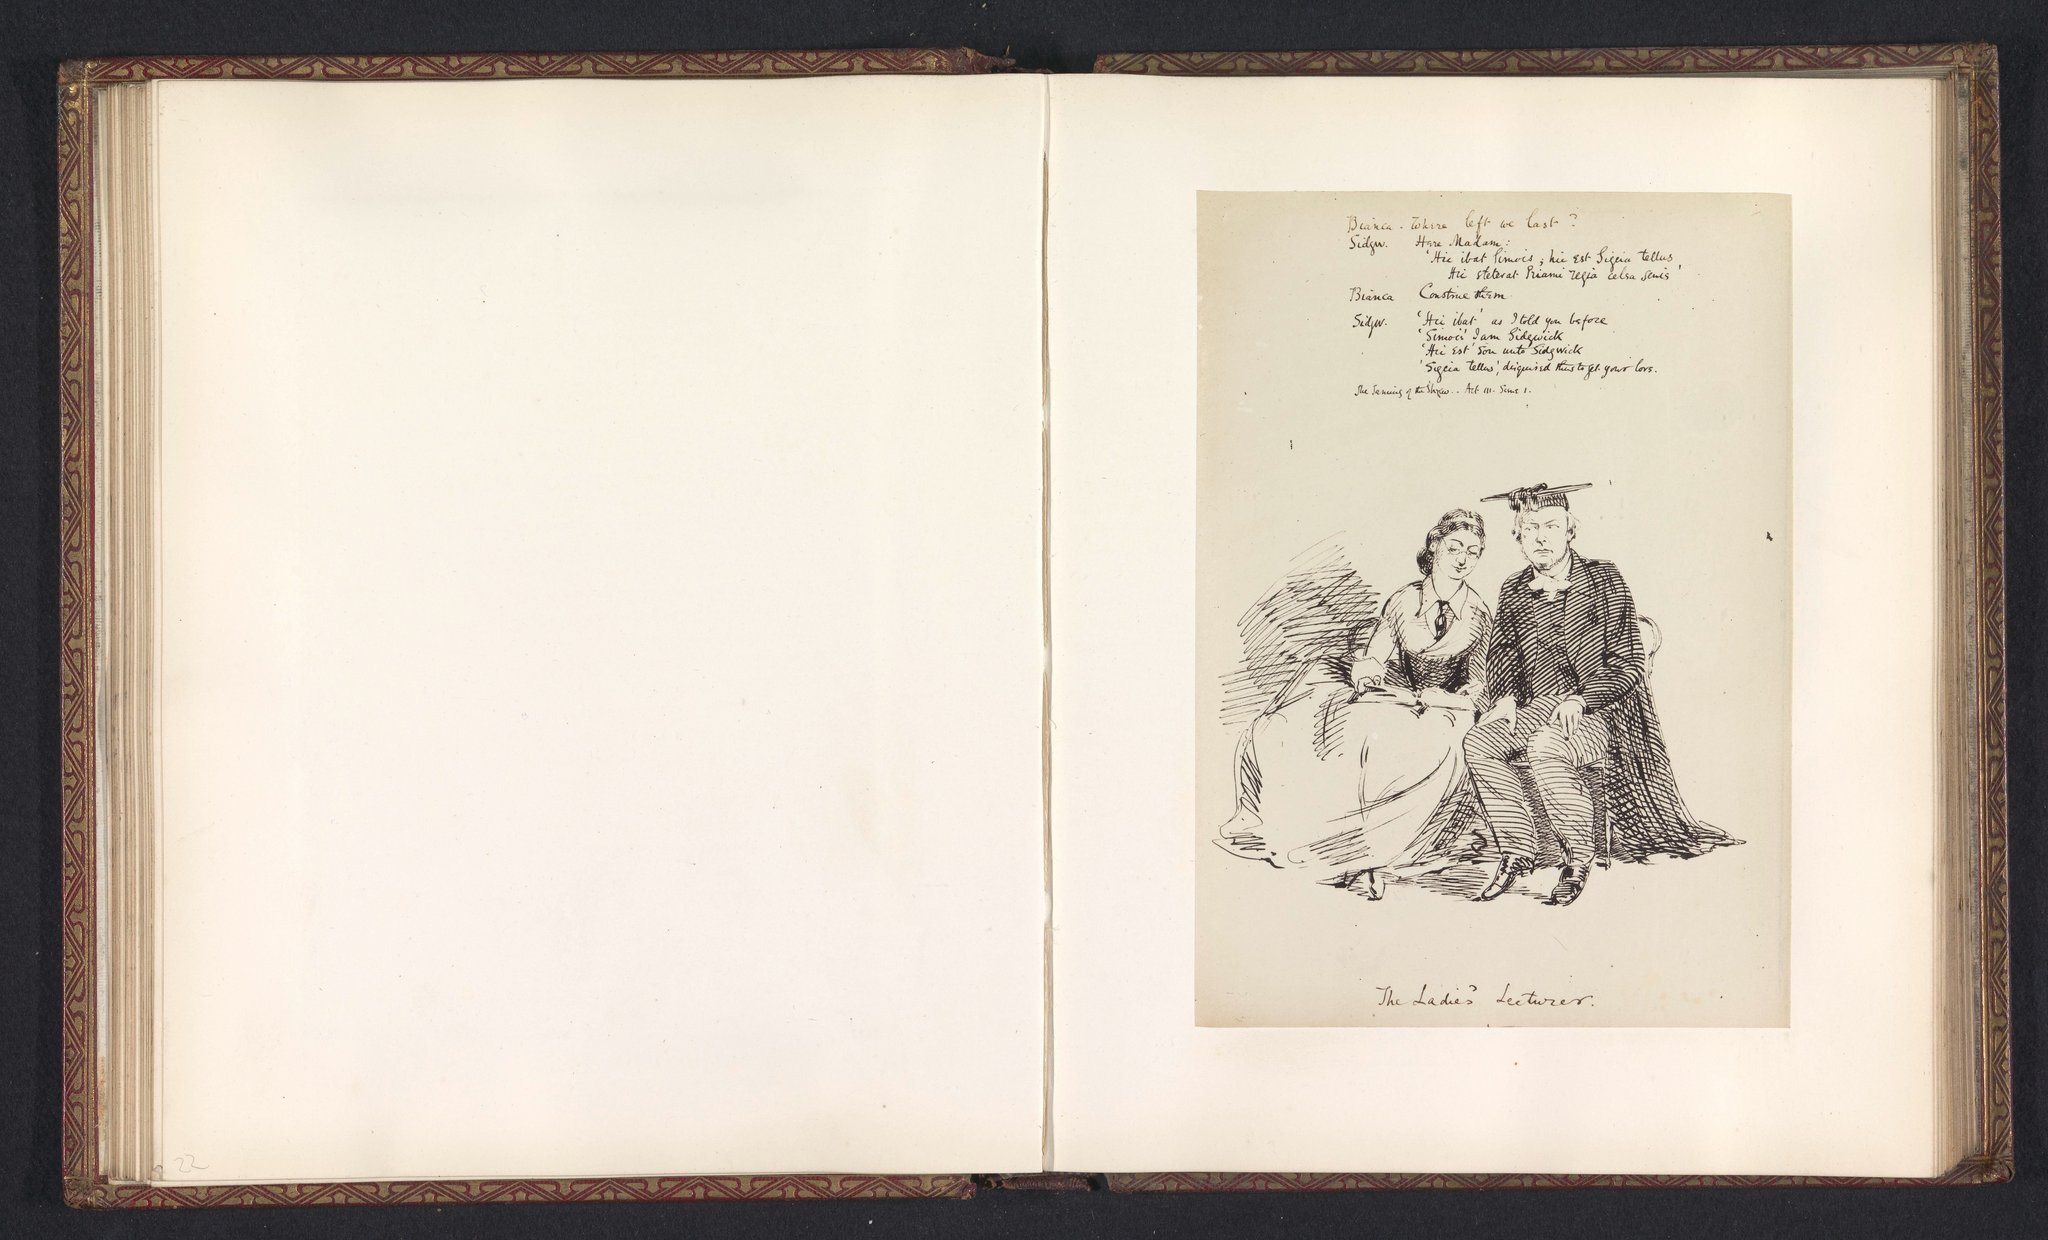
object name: photograph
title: Fotoreproductie van een tekening, voorstellende eerwaarde W. C. Sidgwick naast een vrouwelijke student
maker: Anonymous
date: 1855-1866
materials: photographic support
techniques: albumen print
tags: caricatures (human types), student - bb - female student, professor, student life